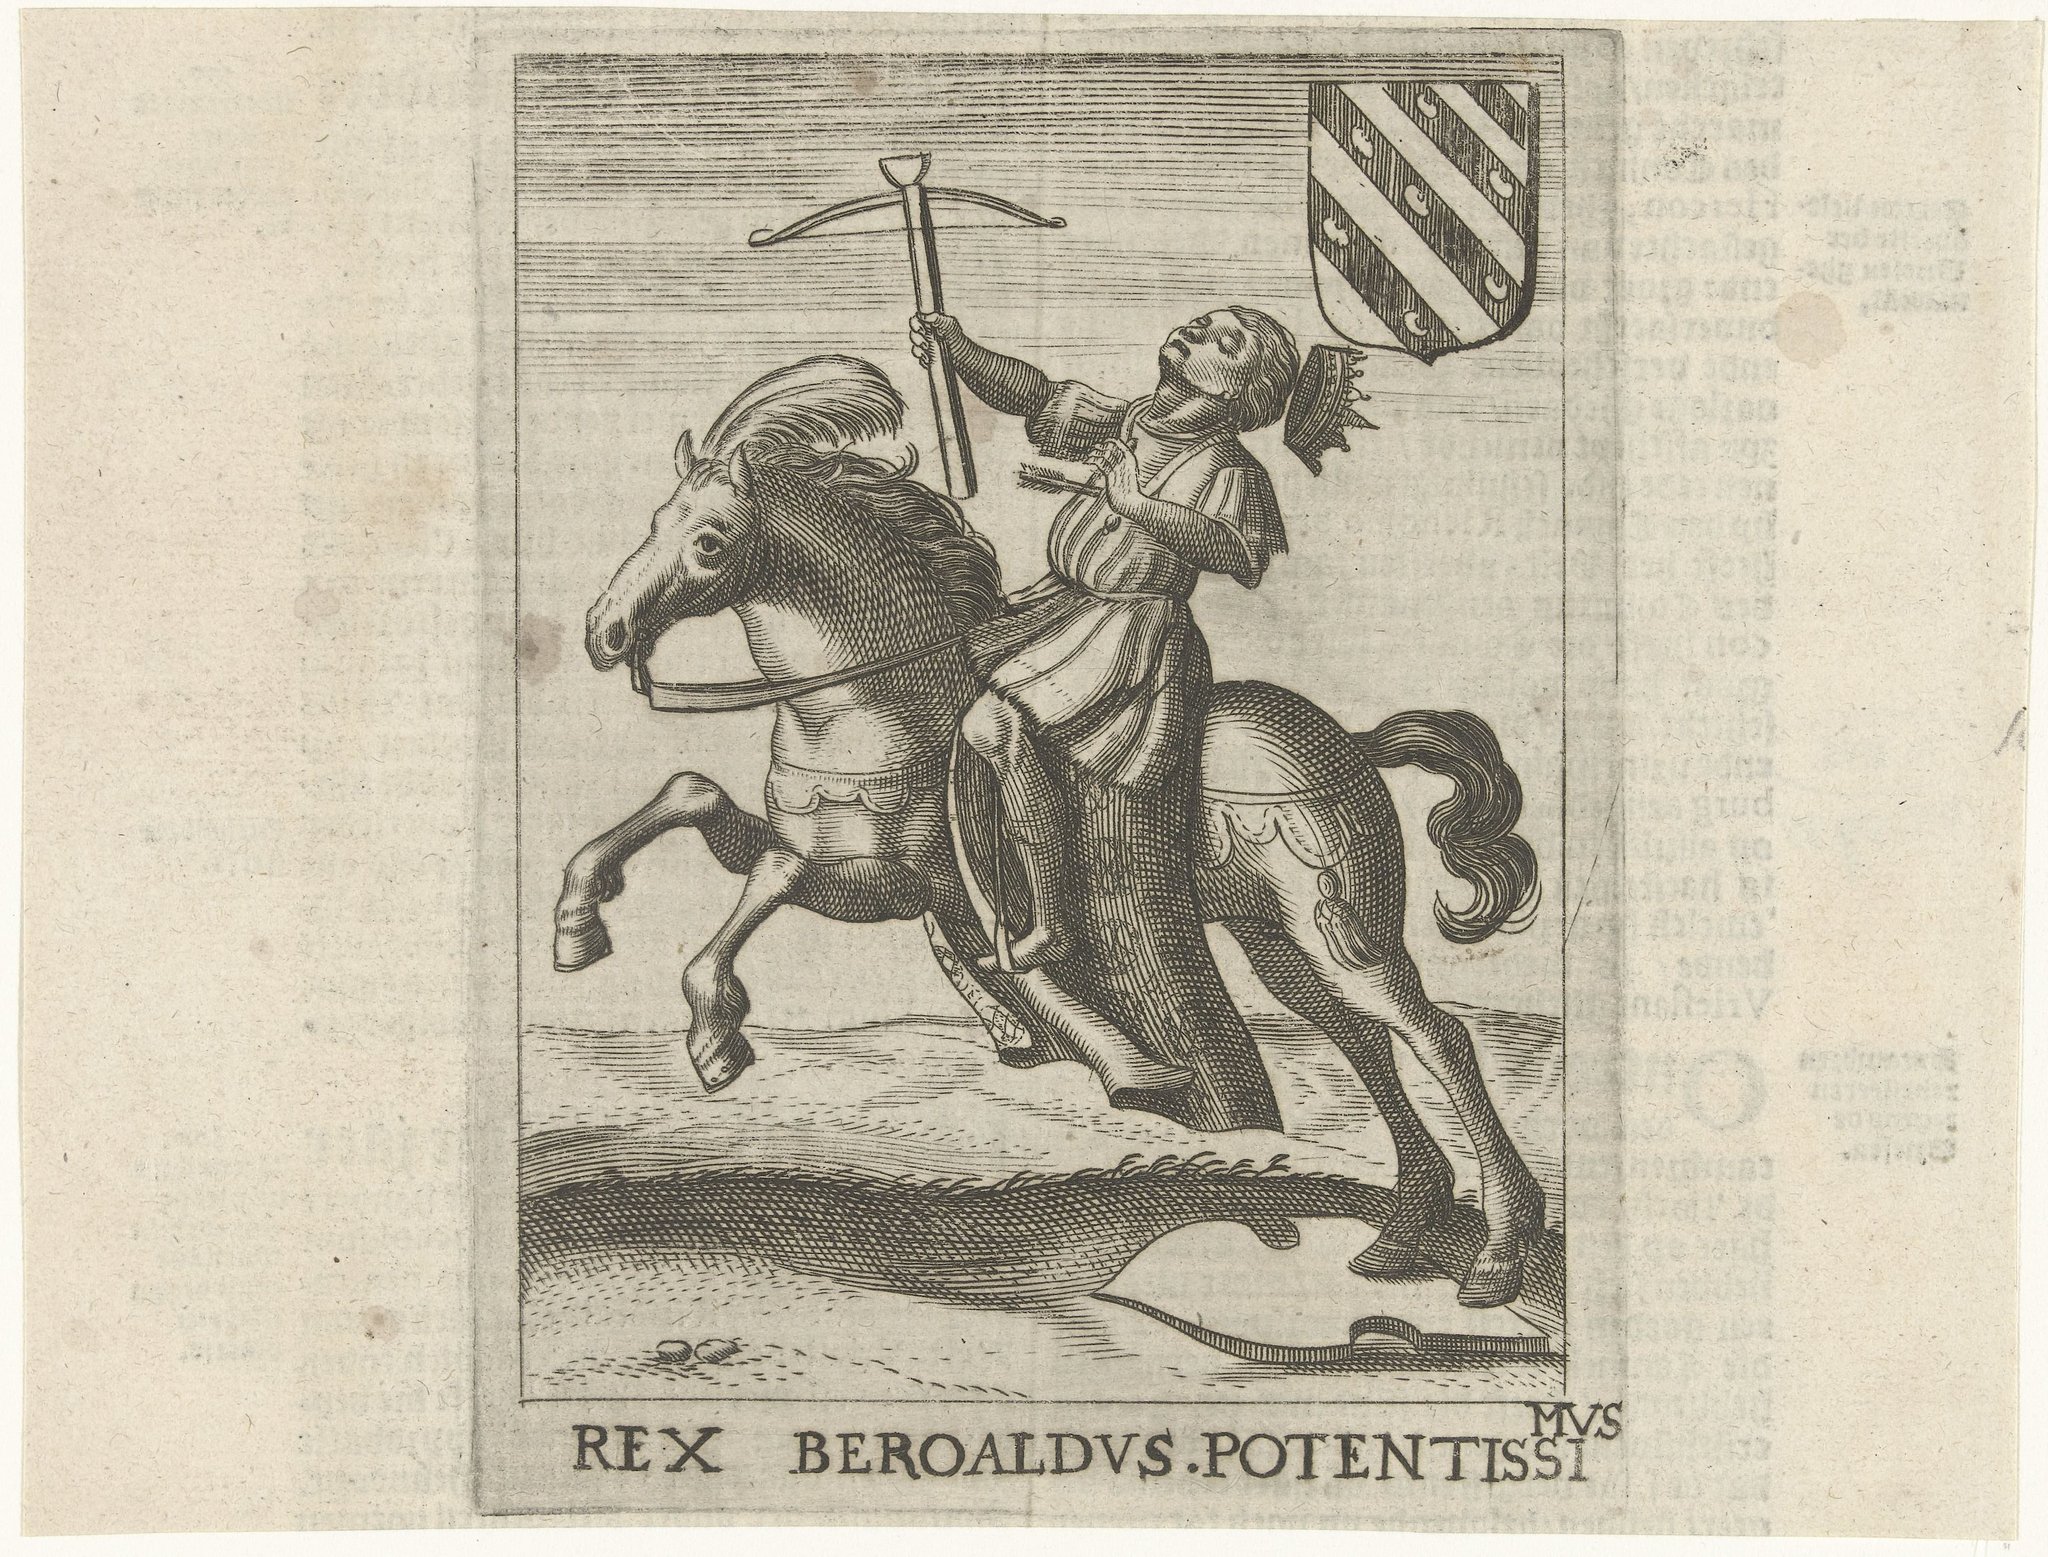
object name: print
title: Beroald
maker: jan lamrinck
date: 1622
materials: paper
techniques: etching, letterpress printing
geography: franeker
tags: beroald (koning der friezen)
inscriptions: collector's mark: Lugt 2228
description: De prent is ook als boekillustratie gebruikt in: Winsemius, P.W. Chronique ofte Historische geschiedenisse van Vrieslant (...). Franeker: Joannes Lamrinck, 1622.